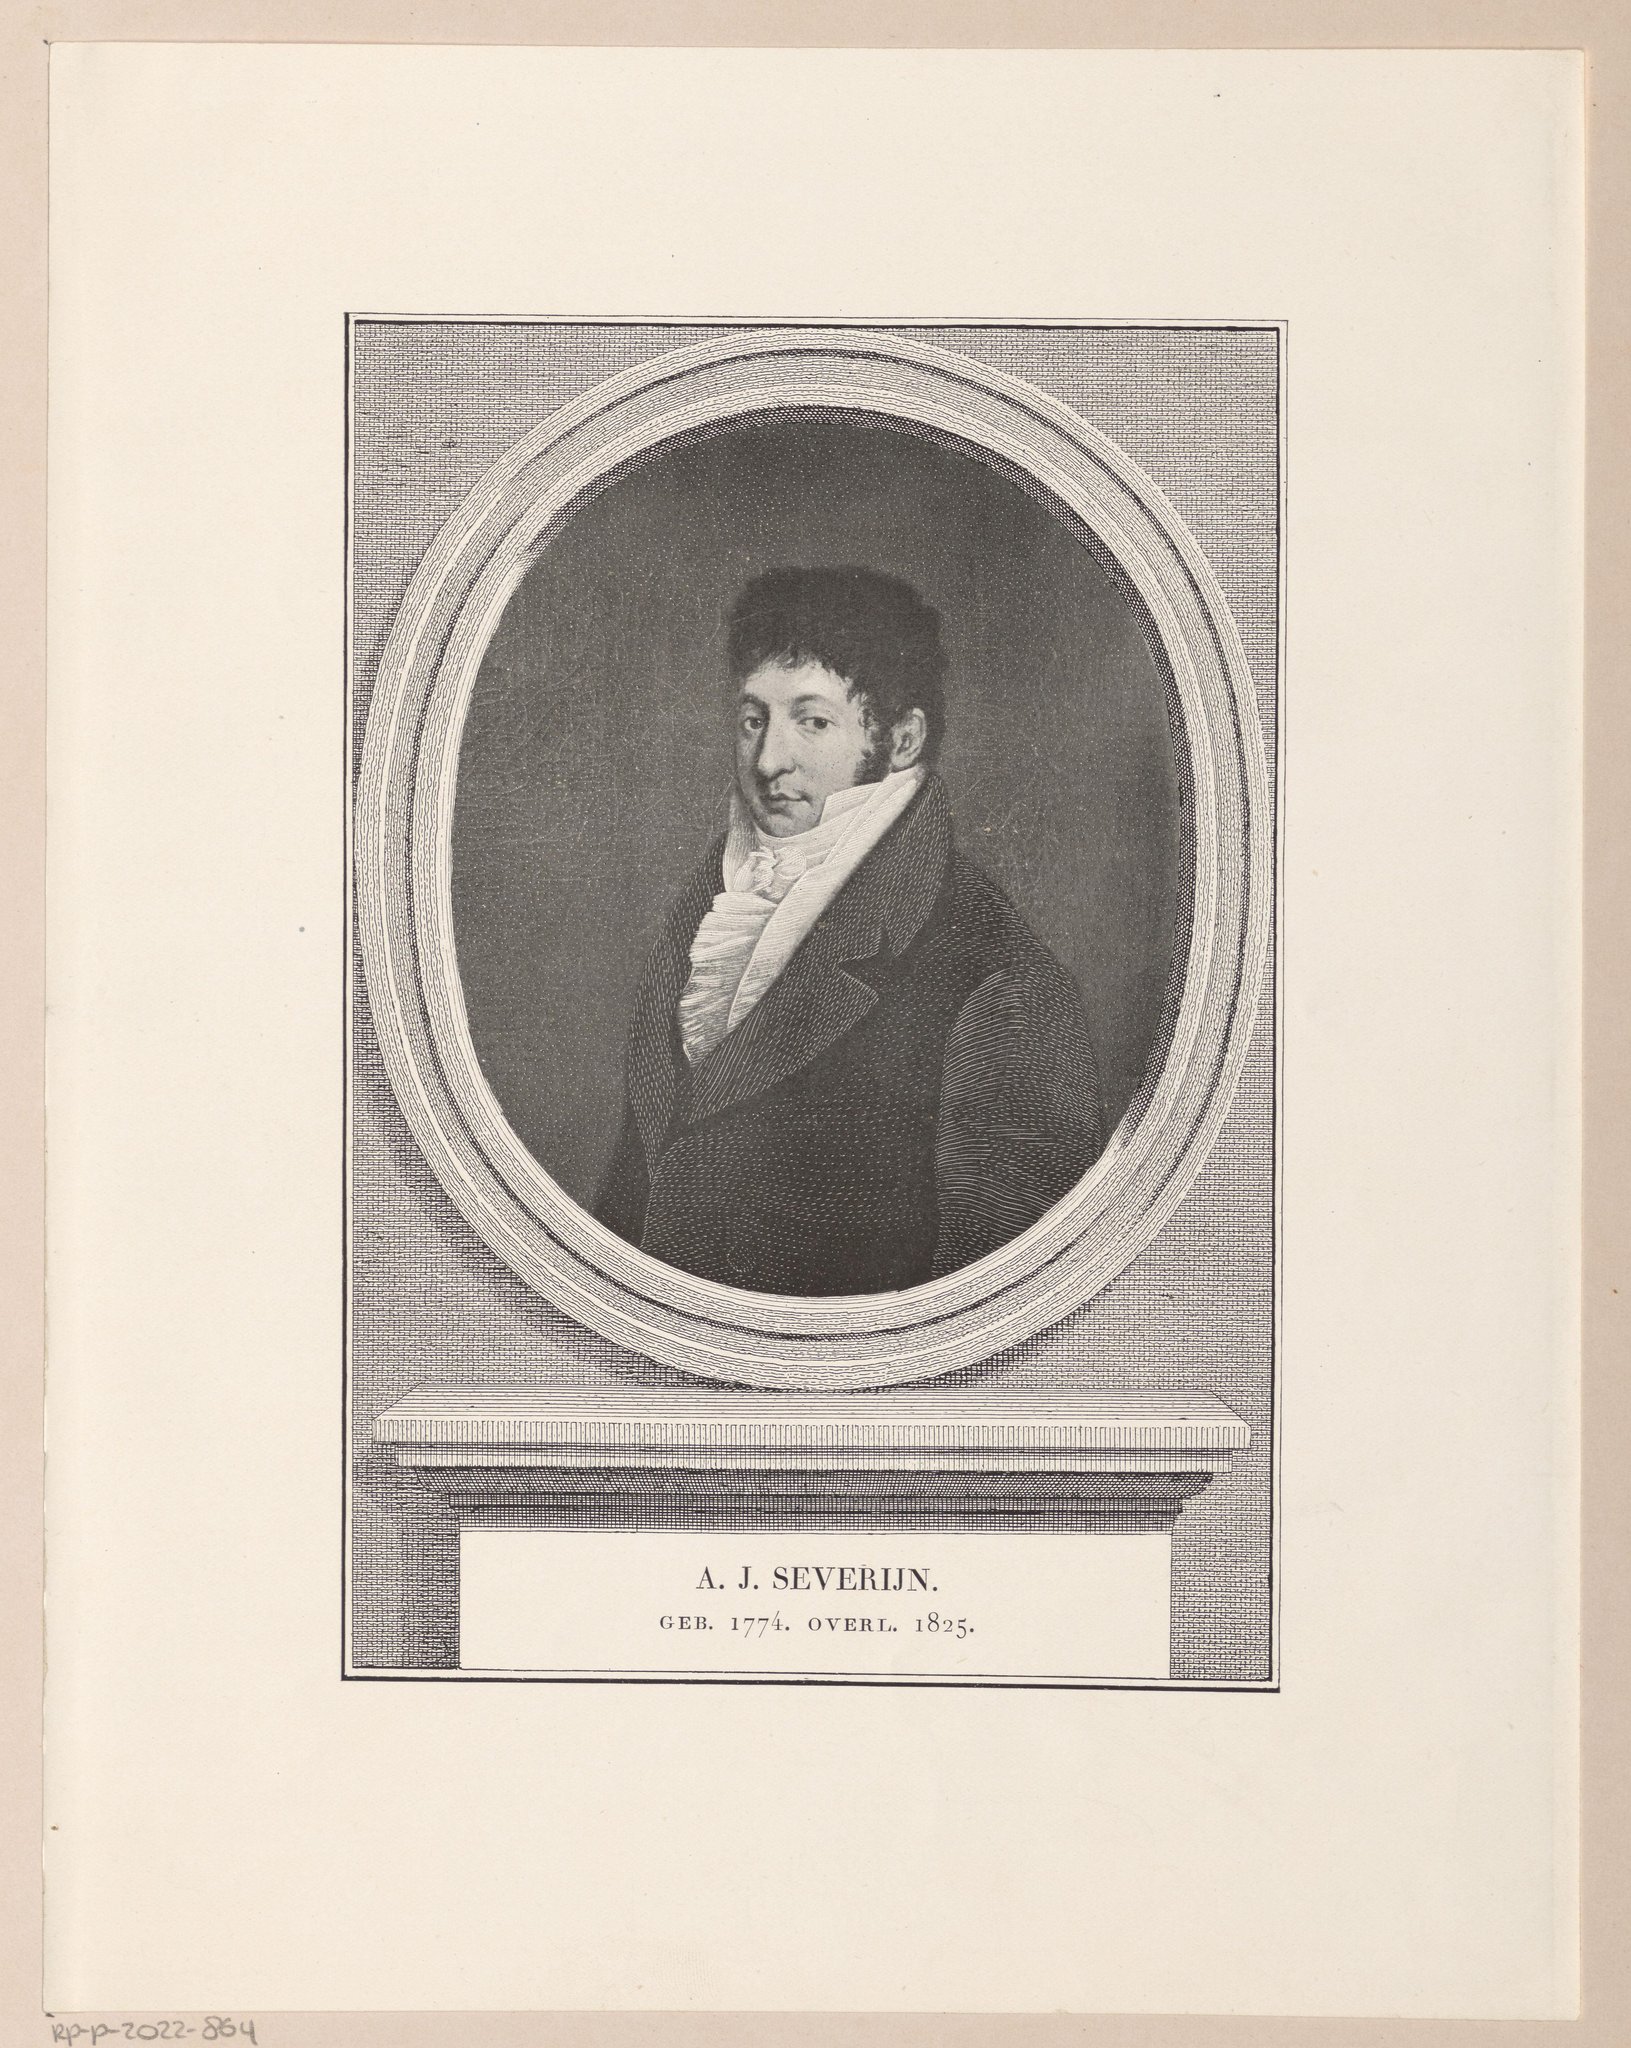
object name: photomechanical print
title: Portret van A.J. Severijn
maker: Anonymous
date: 1882-1970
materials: paper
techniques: autotype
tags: historical persons, merchant, salesman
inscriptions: collector's mark: Lugt 2228